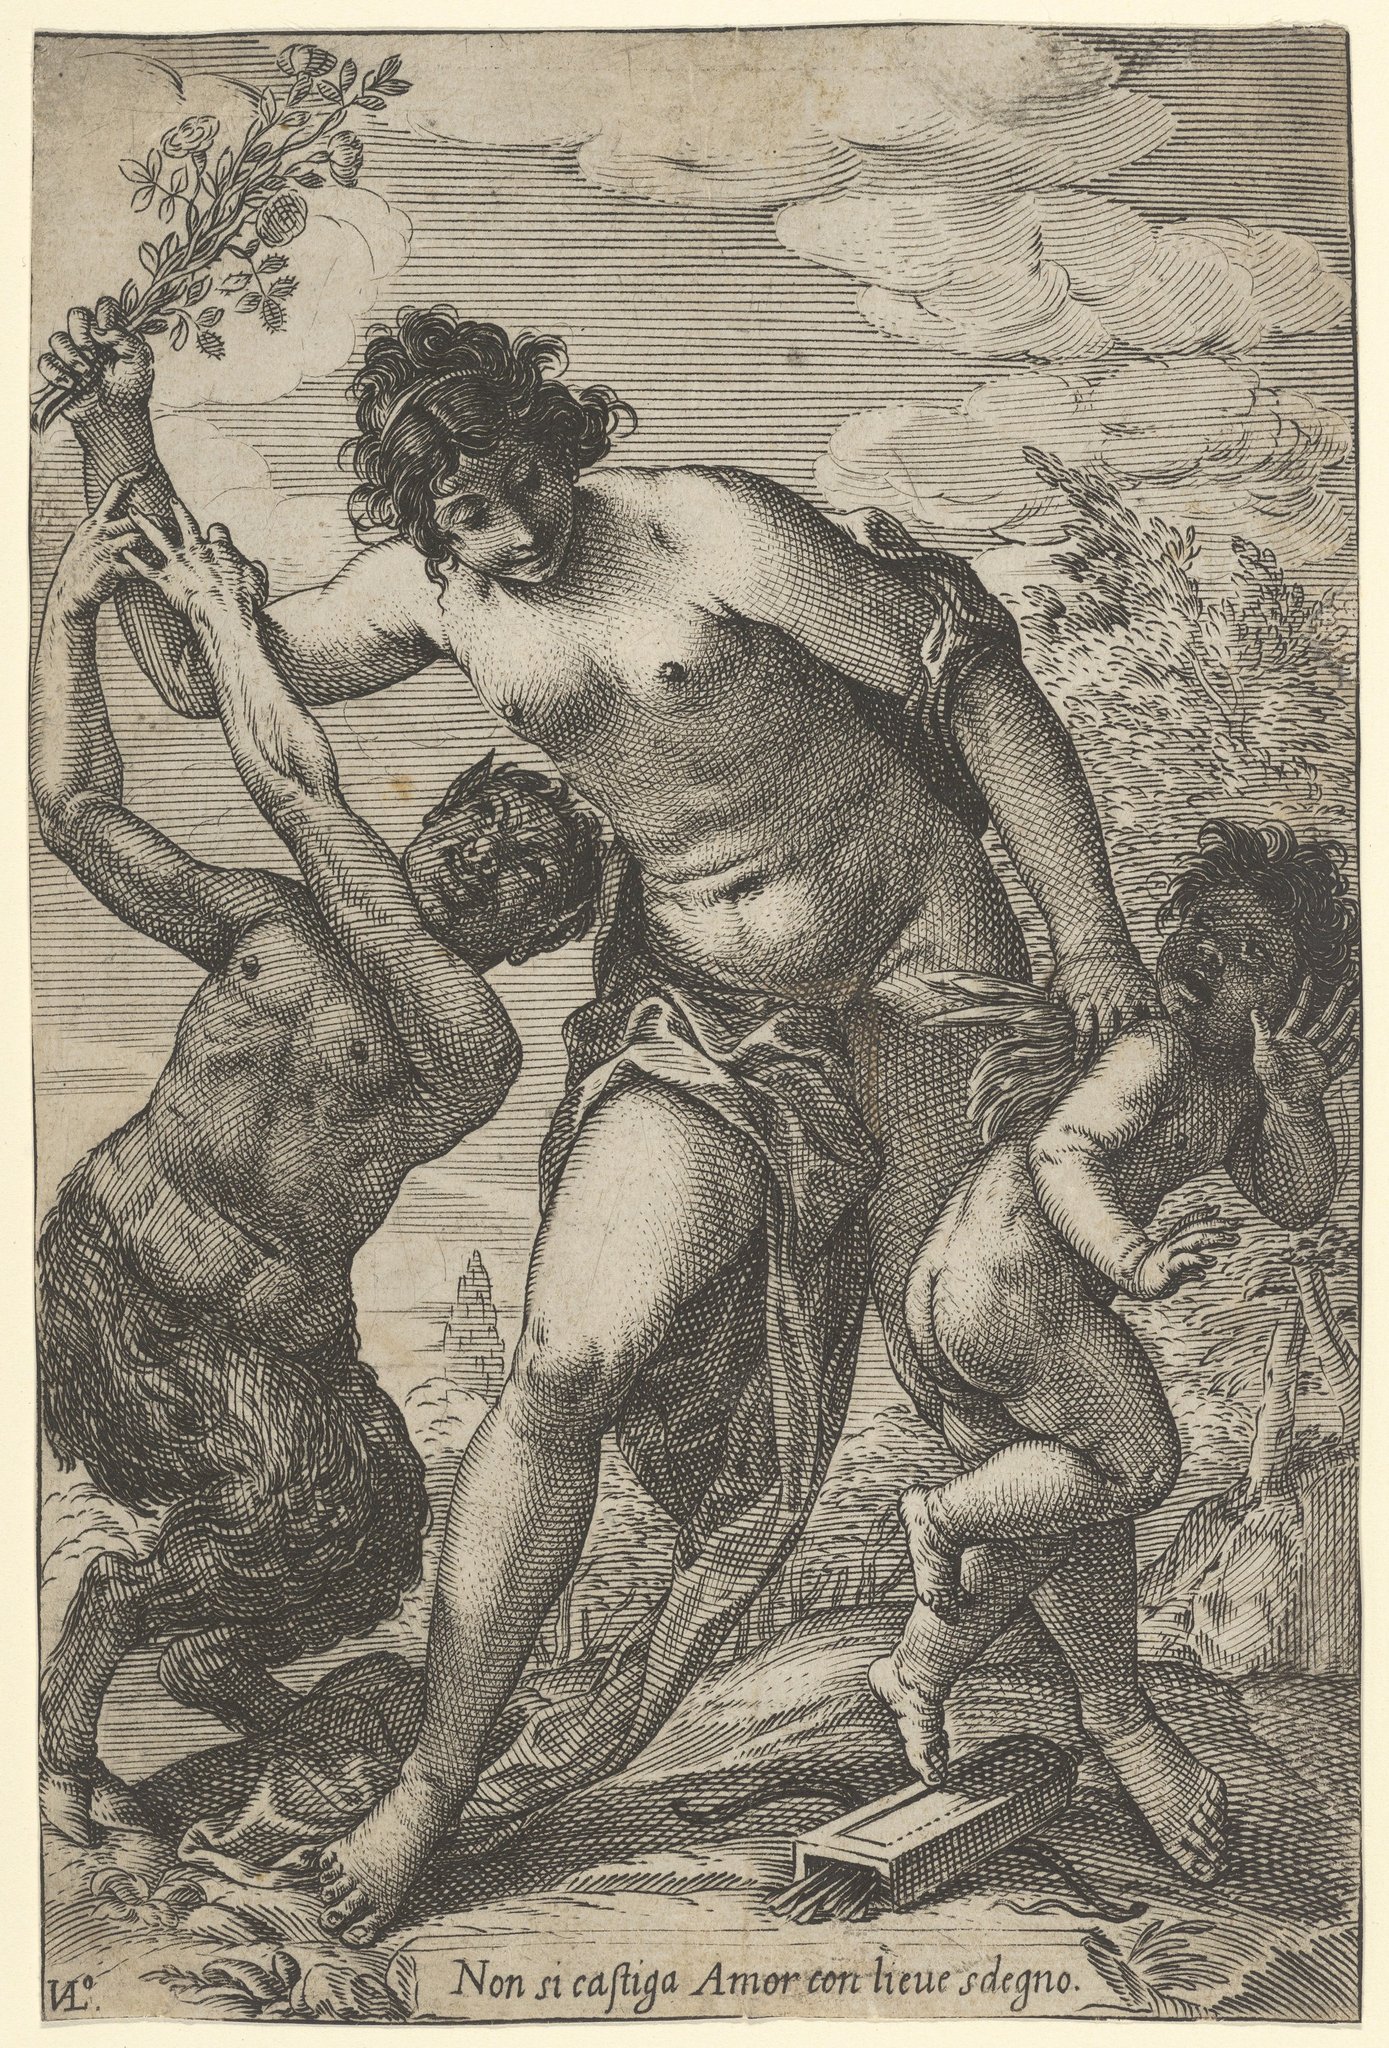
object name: print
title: Venus Whipping Cupid with Roses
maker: giovanni luigi valesio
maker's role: artist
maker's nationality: italian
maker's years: 1583-1633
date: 1601-1633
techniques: engraving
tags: cupid,venus,satyrs